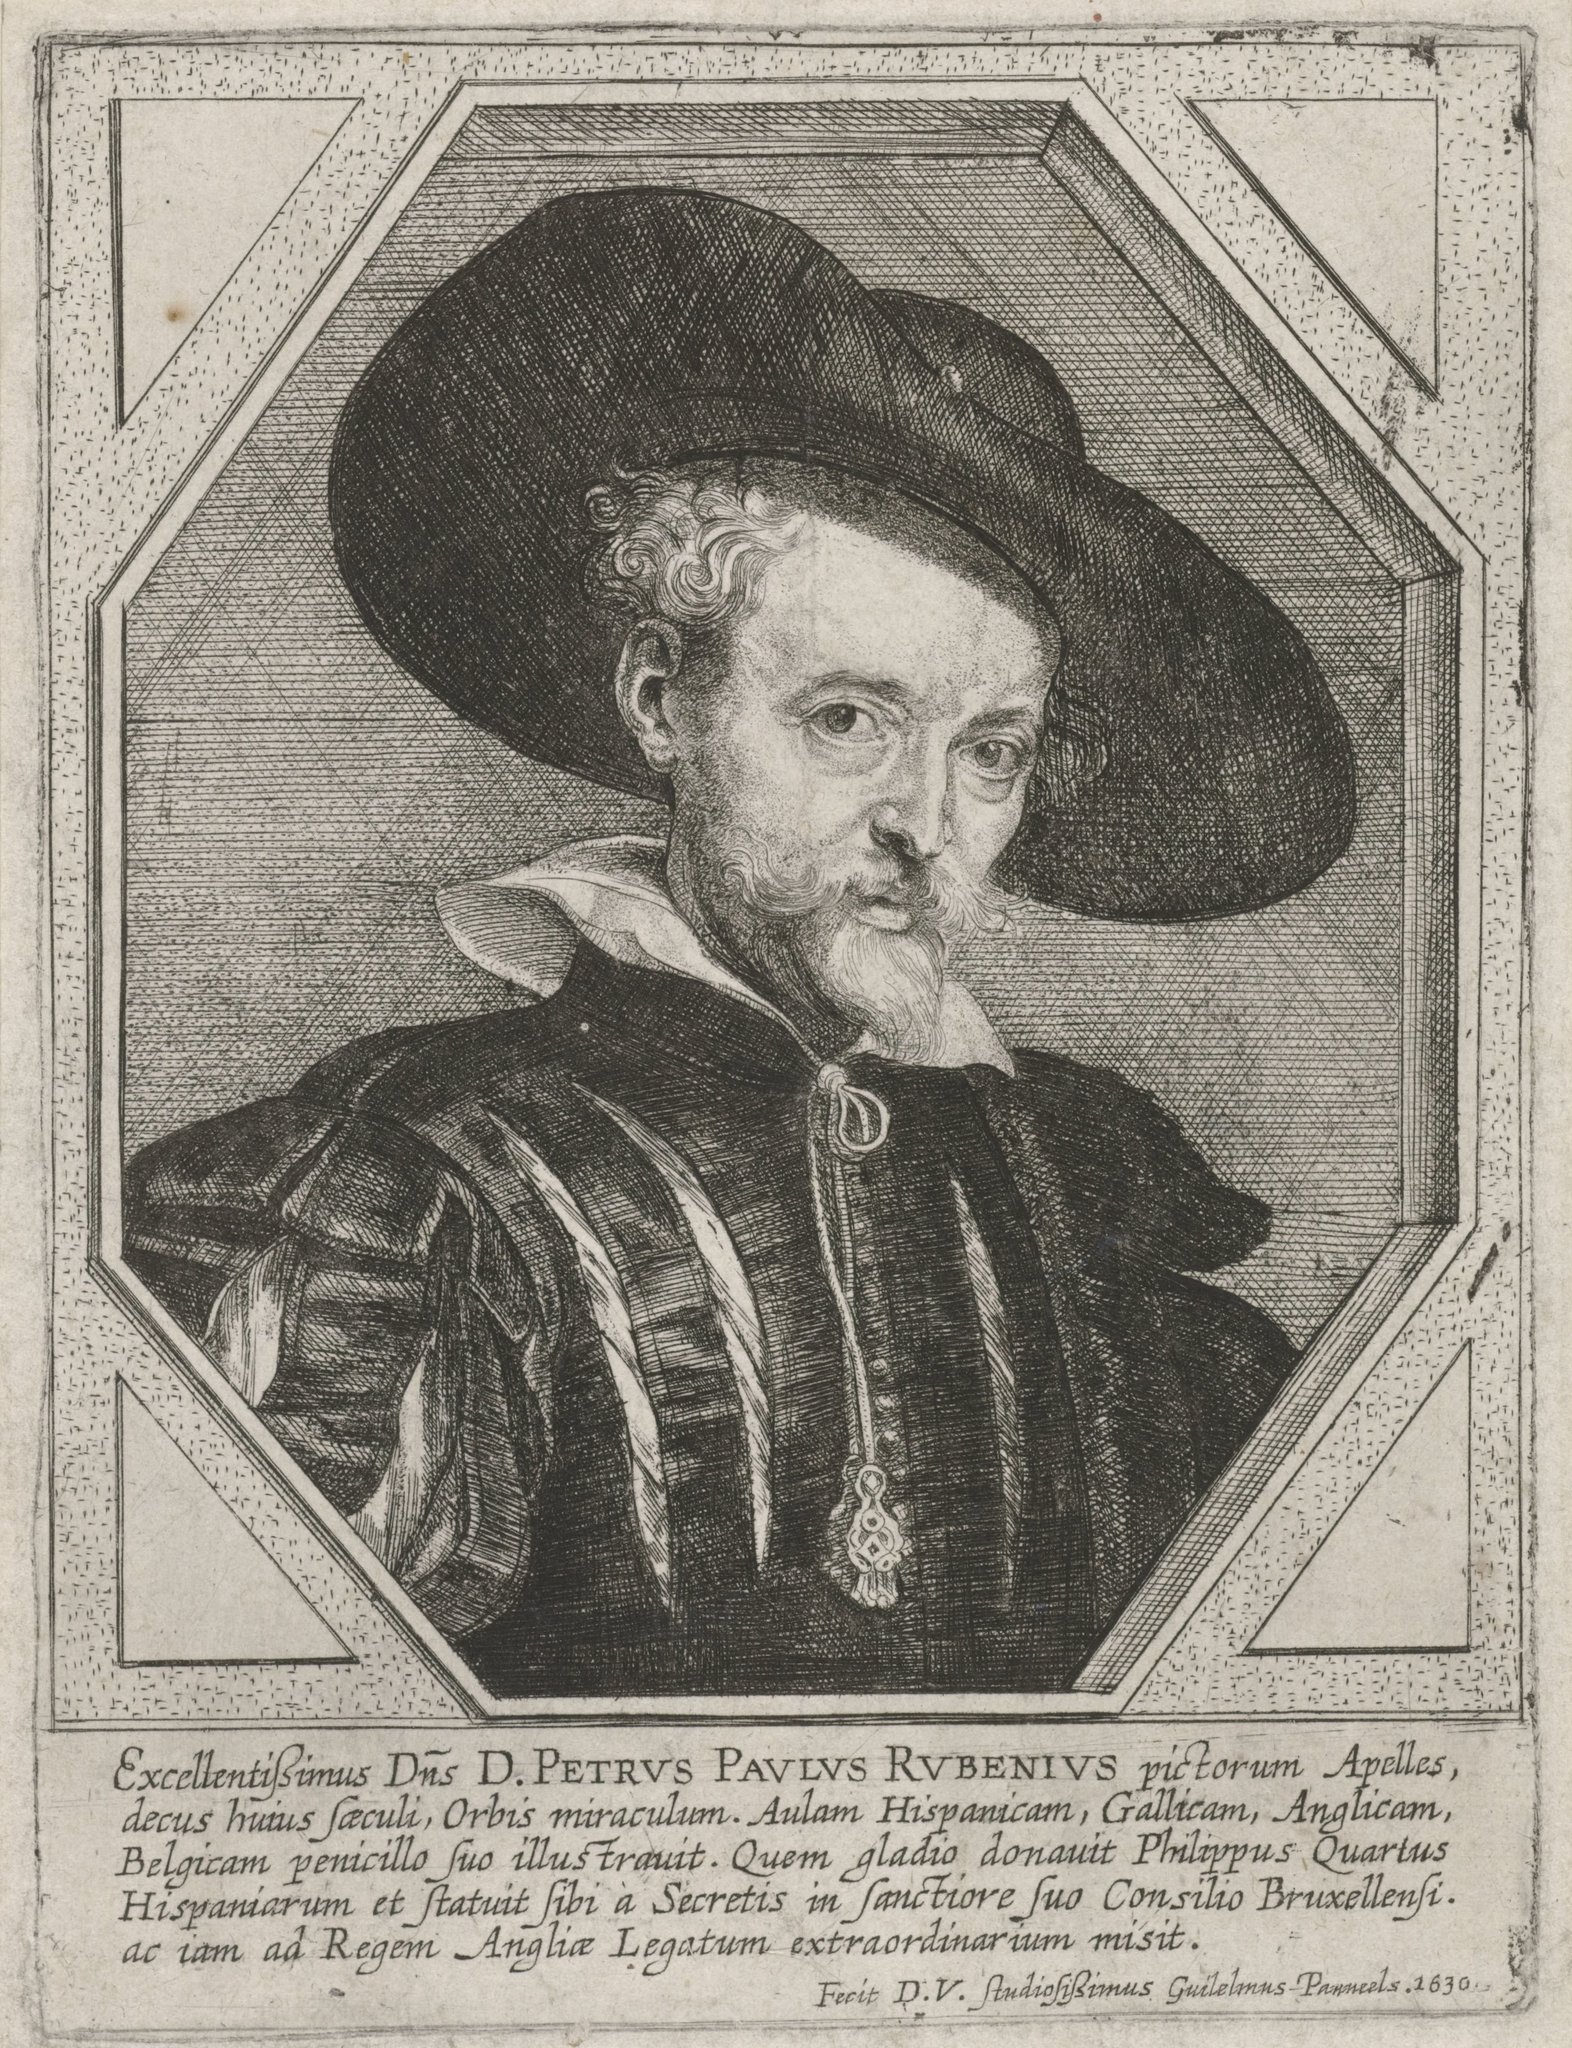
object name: print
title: Portret van Peter Paul Rubens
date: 1630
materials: paper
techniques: engraving, etching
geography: antwerp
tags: antwerp, painter, draughtsman, peter paul rubens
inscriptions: collector's mark: Lugt 240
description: Busteportret van Peter Paul Rubens, met hoed. Het portret is gevat in een achthoekige omlijsting met vierkant randwerk. In de marge een vijfregelig onderschrift in het Latijn.